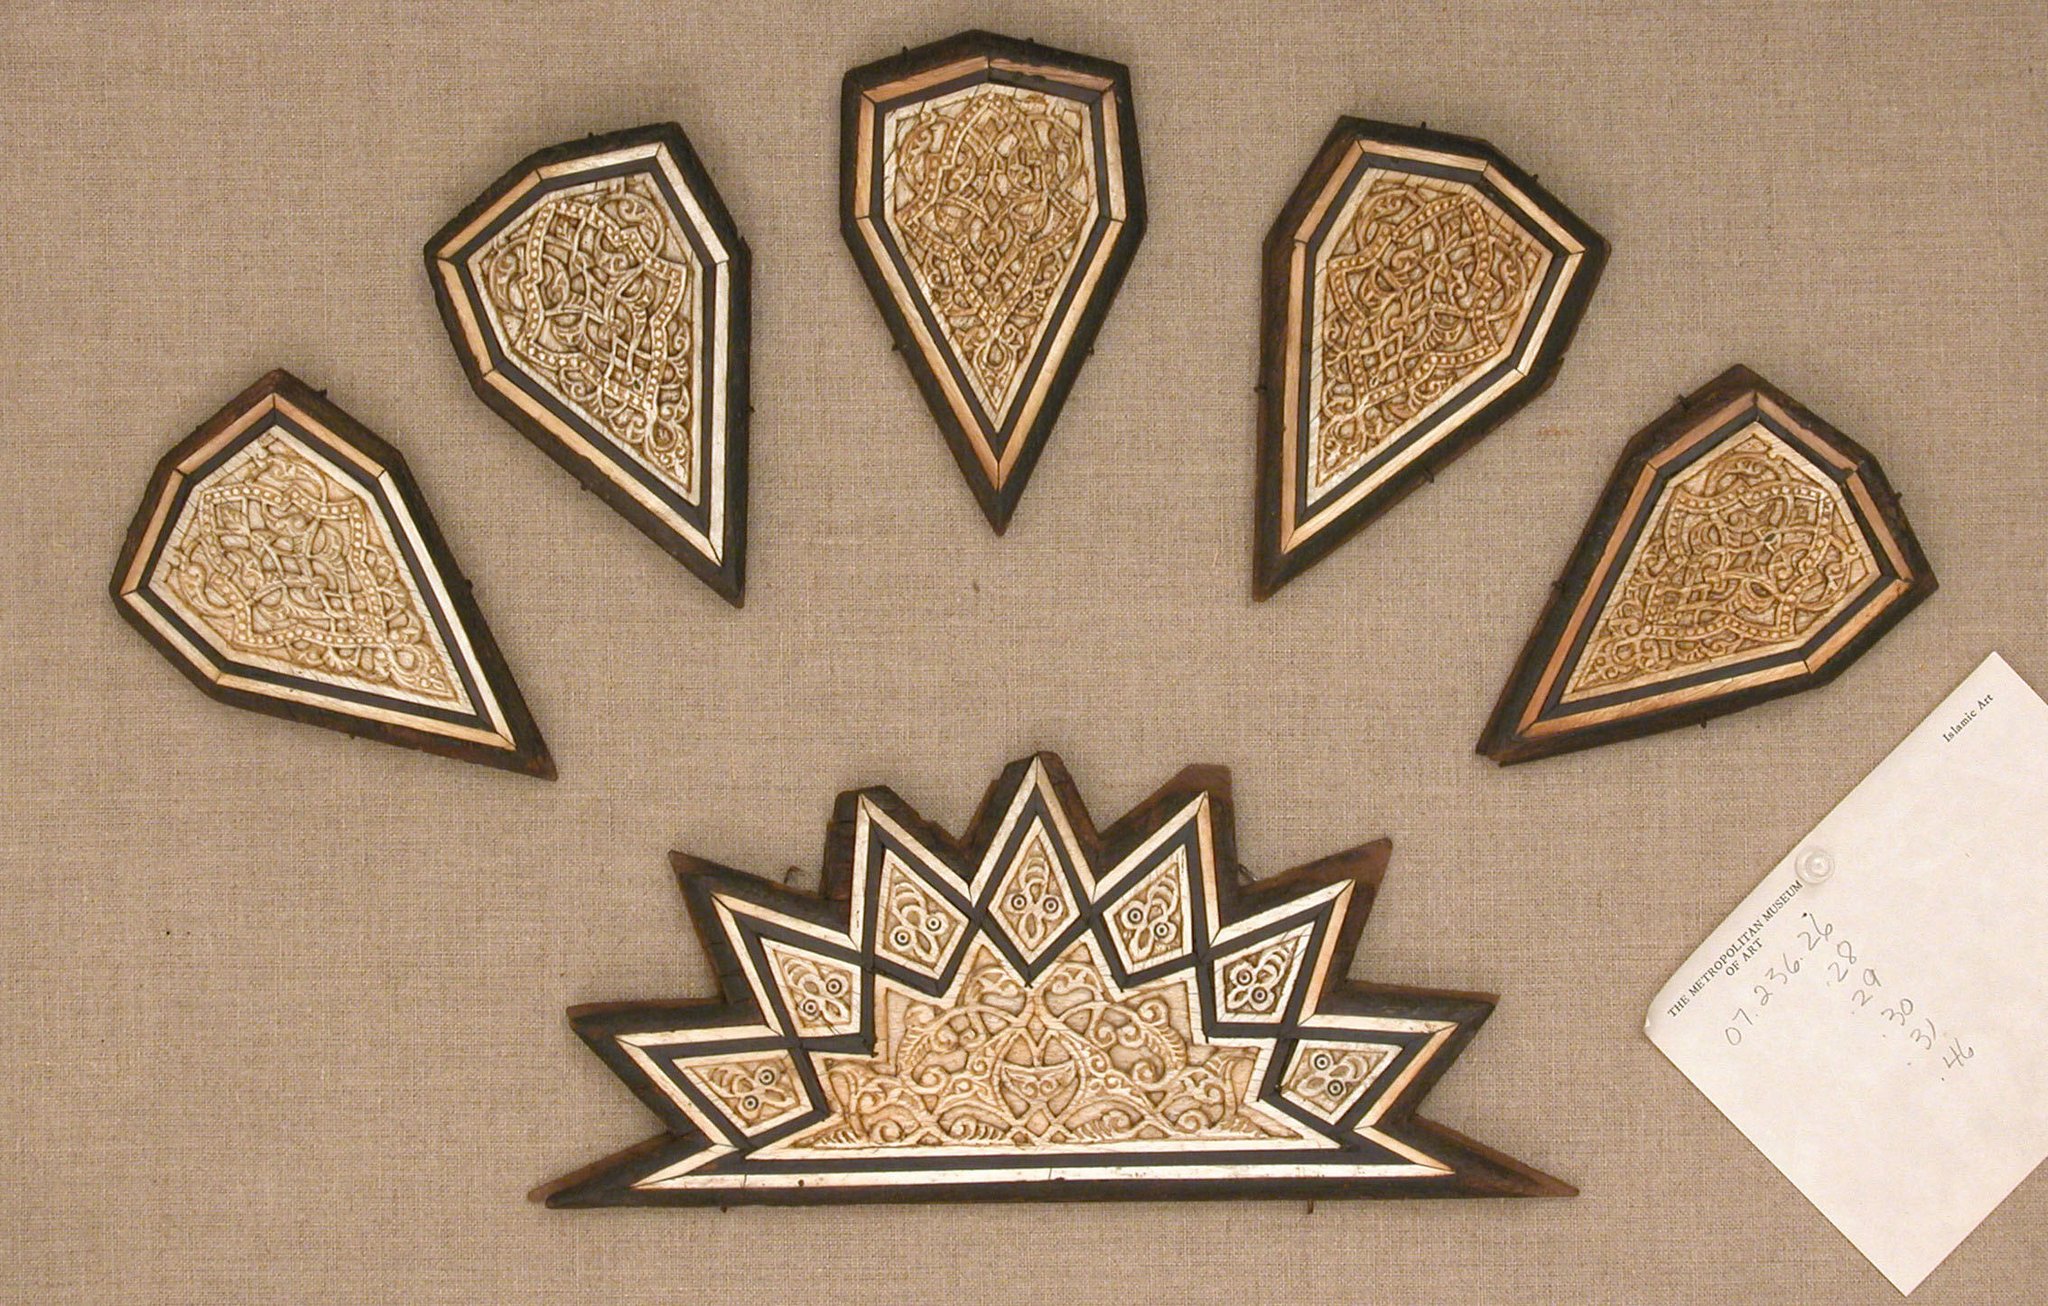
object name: panel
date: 1201-1300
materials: ivory, wood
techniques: carving, inlay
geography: egypt